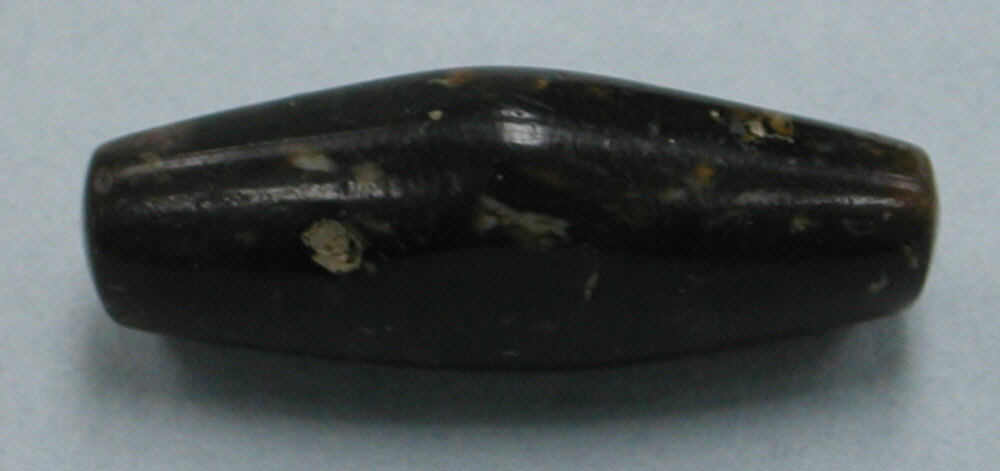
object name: ritual stone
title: Stone Pulidor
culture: mexican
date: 1501-1600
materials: stone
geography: mexico